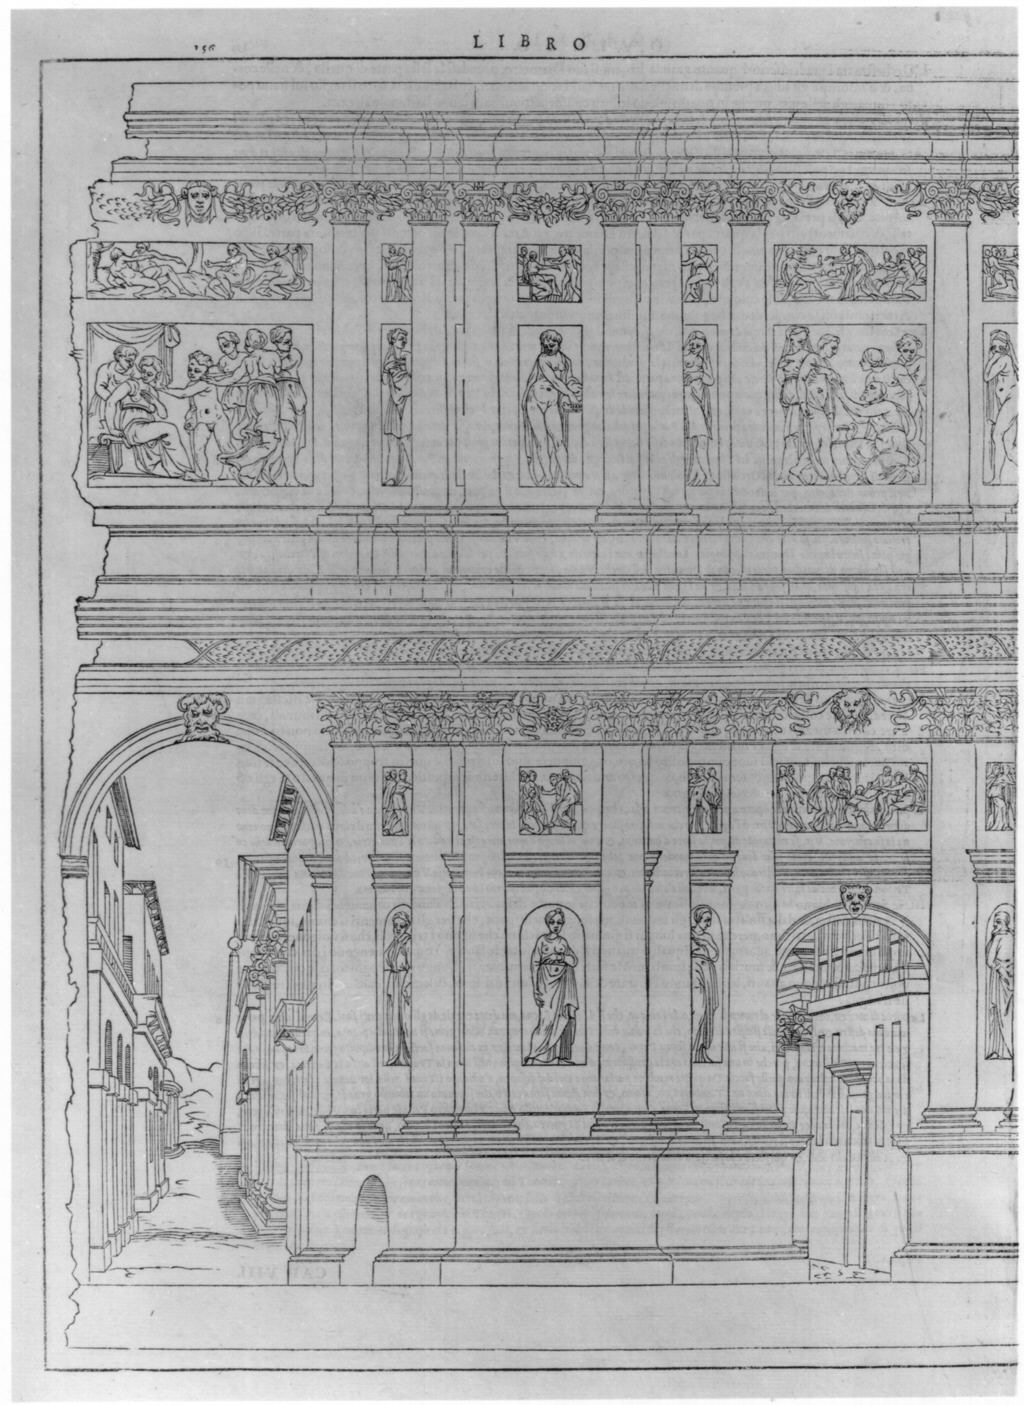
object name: book print ornament architecture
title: I dieci libri dell'architettura di M. Vitruvio tradutti et commentati da monsignor Barbaro eletto patriarca d'aquileggia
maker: marcus pollio vitruvius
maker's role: author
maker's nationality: italian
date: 1556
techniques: printing, woodcut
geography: italy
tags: architecture,buildings